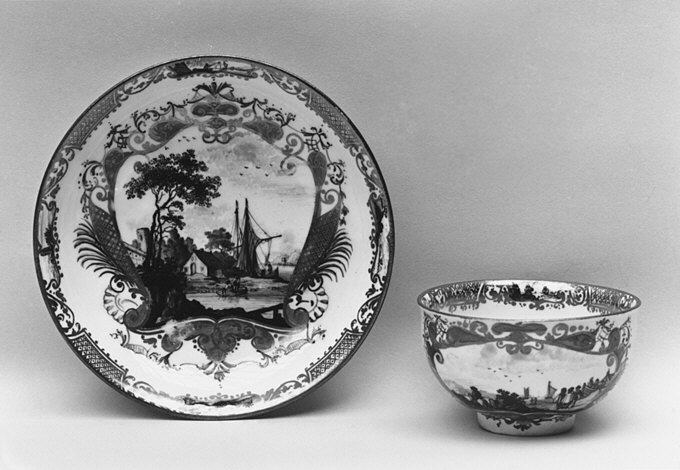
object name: cup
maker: meissen manufactory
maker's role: manufactory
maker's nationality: german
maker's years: 1710-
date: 1735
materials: hard paste porcelain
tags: human figures,boats